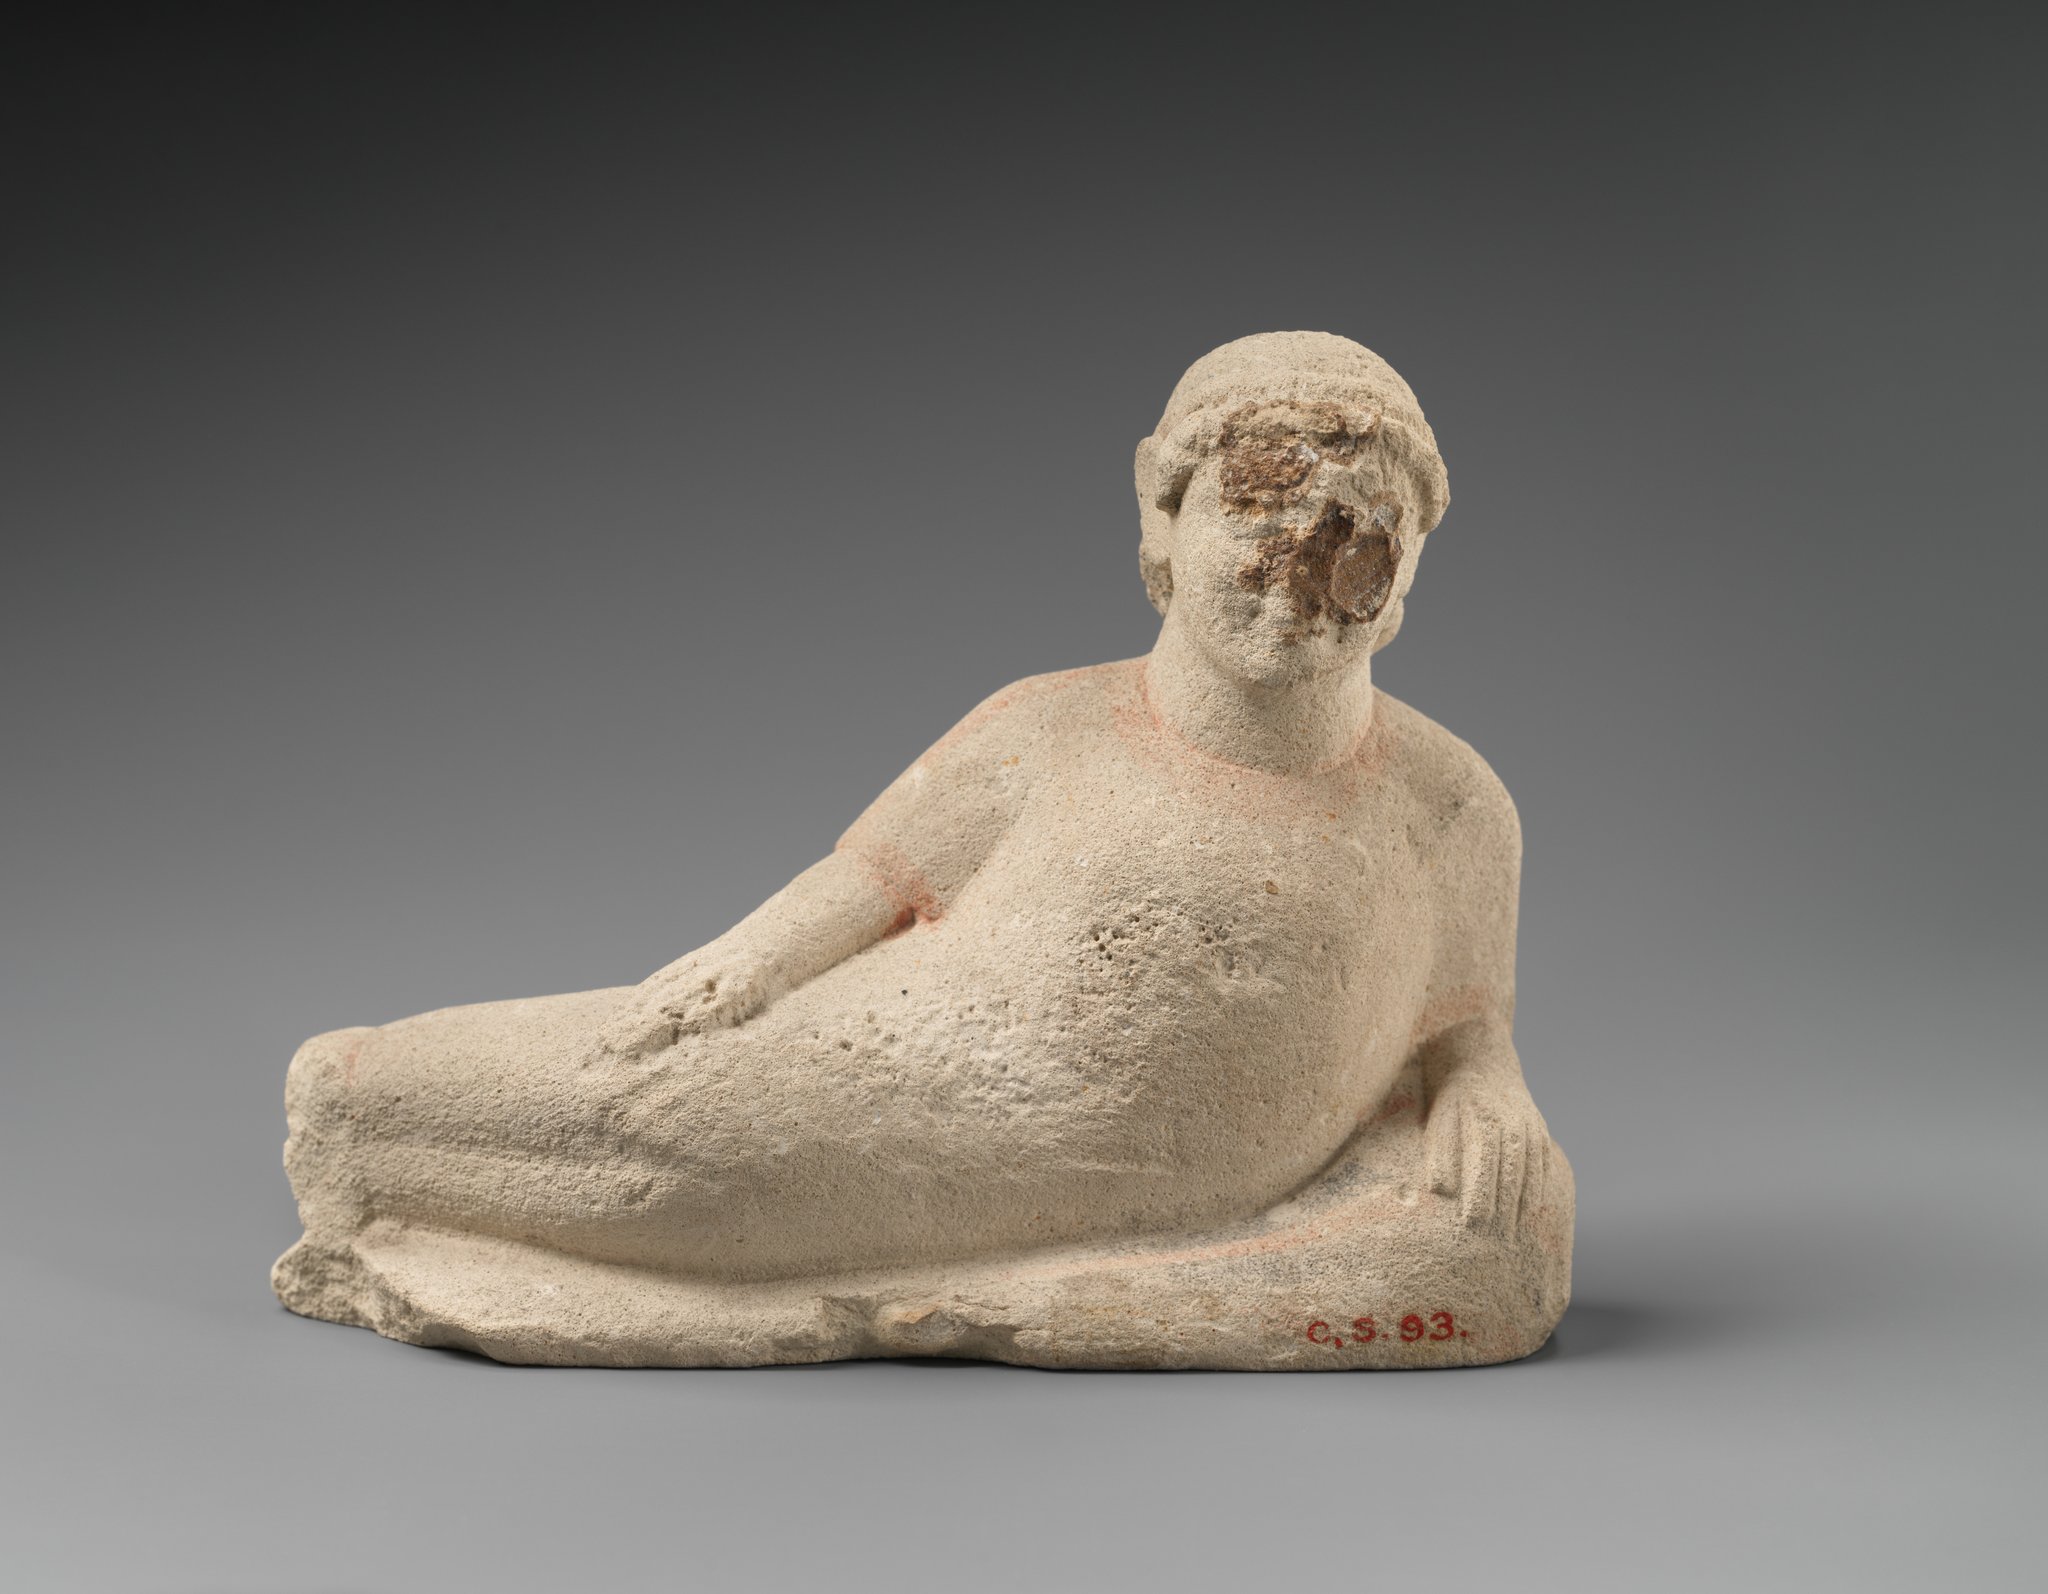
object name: statue of a votary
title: Limestone male banqueter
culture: cypriot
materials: limestone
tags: men